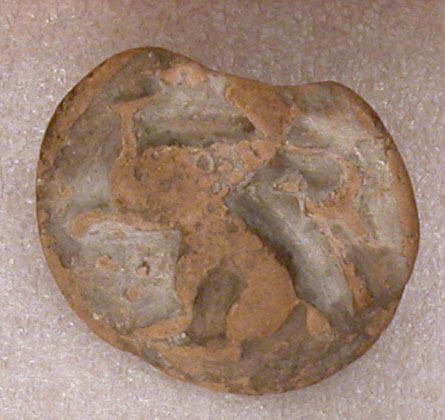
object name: seal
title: Bread Seal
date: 901-1000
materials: earthenware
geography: egypt